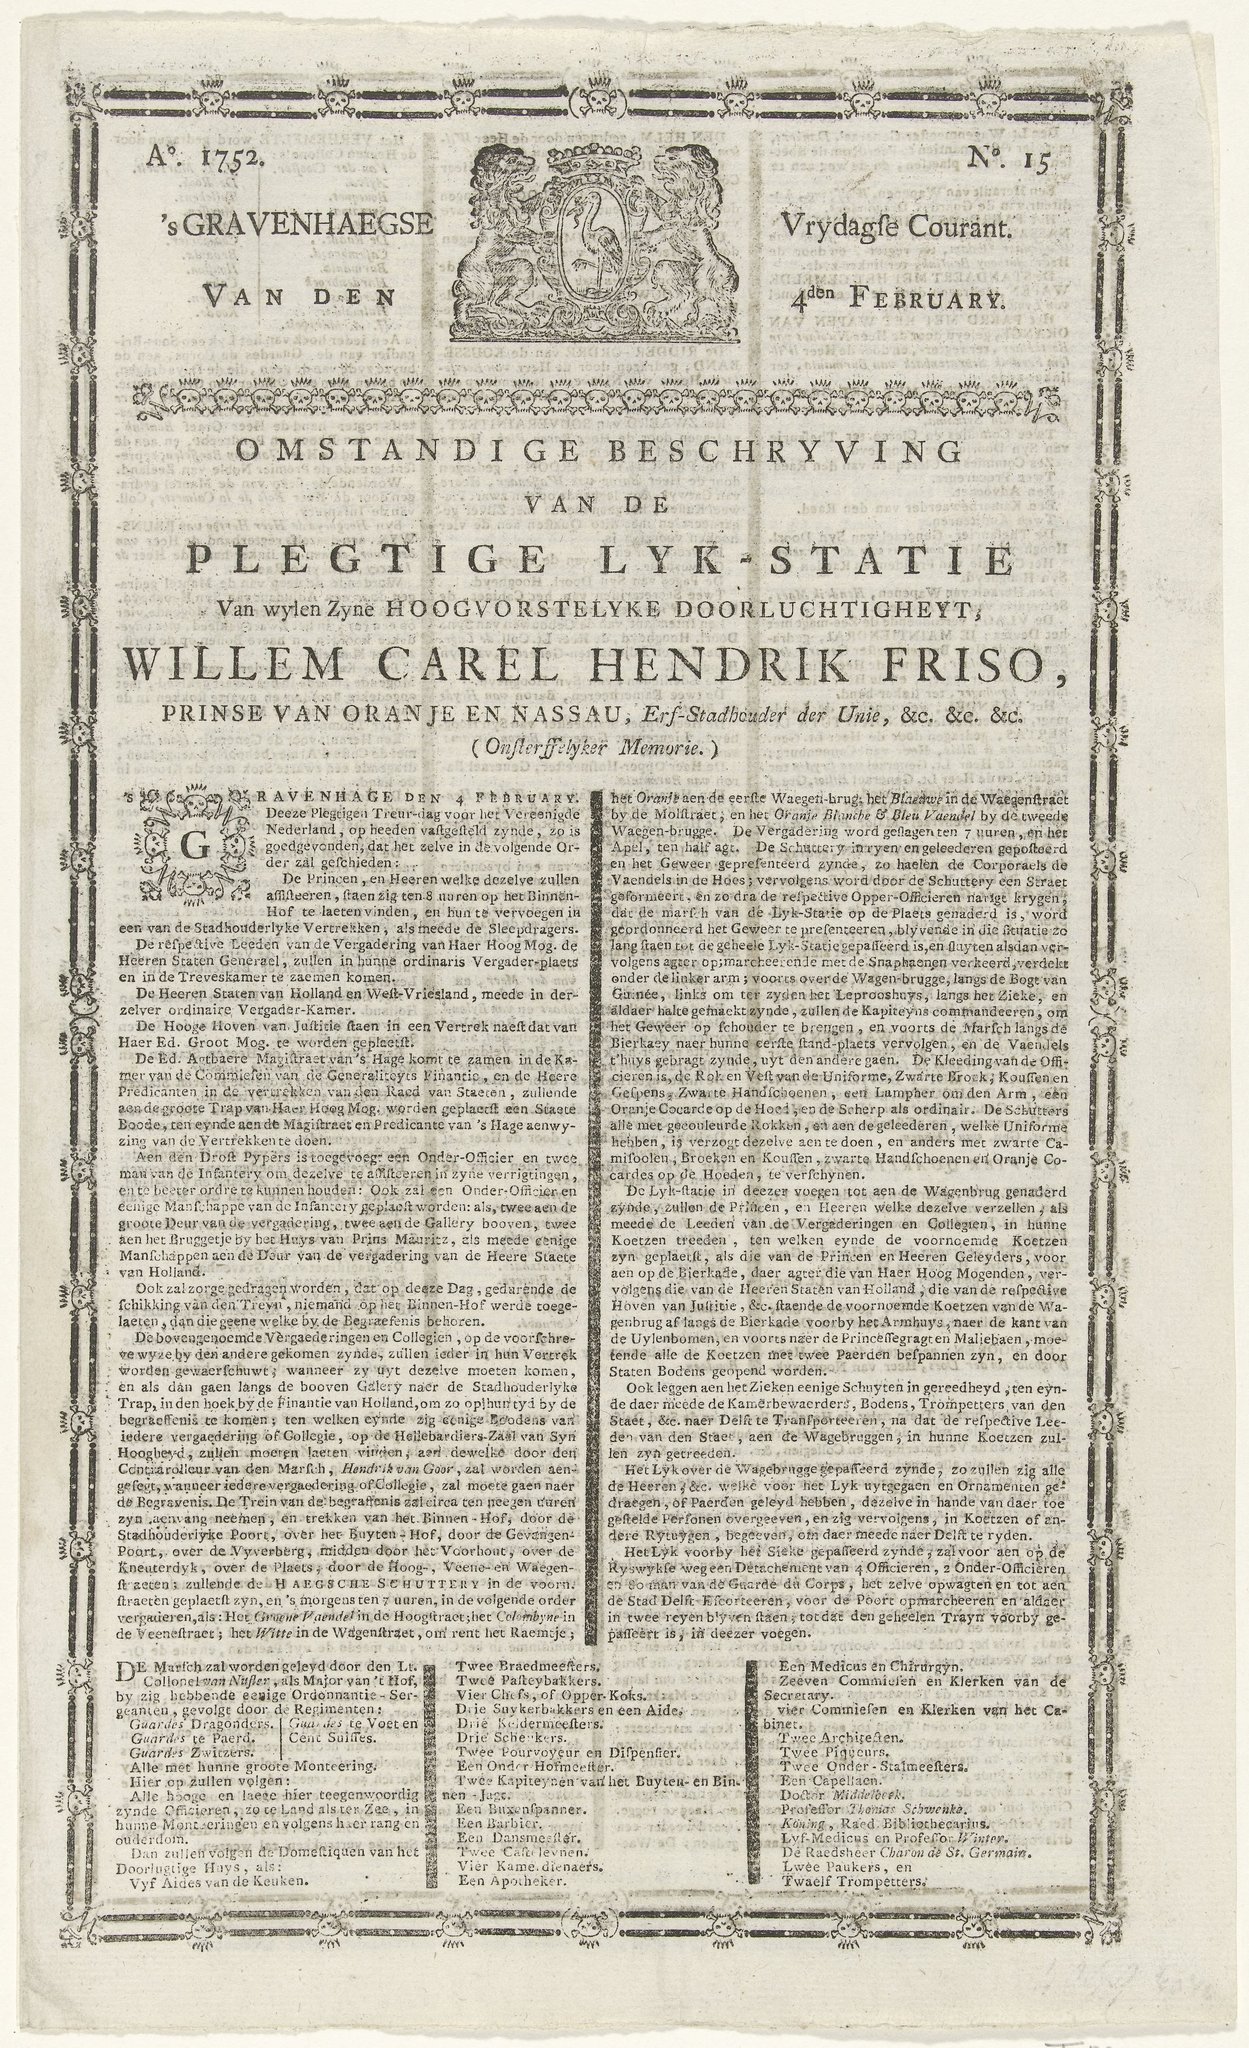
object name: newspaper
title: 'sGravenhaegse Vrydagse Courant van den 4den February / Omstandige Beschryving van de Plegtige Lyk-statie van wylen Zyne Hoogvorstelyke Doorluchtigheyt, Willem Carel Hendrik Friso (...)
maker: anthoni de groot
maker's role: publisher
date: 1752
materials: paper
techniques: letterpress printing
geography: the hague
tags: willem iv (prins van oranje-nassau), delft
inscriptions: collector's mark: Lugt 2228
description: Aflevering van de 'sGravenhaegse Vrydagse Courant van vrijdag 4 februari 1752 met een beschrijving van de rouwstoet van stadhouder Willem IV zoals die plaatsvond te Delft op die dag. Dubbelgevouwen blad op vier bladzijden bedrukt, de eerste twee bladzijden met rouwranden.